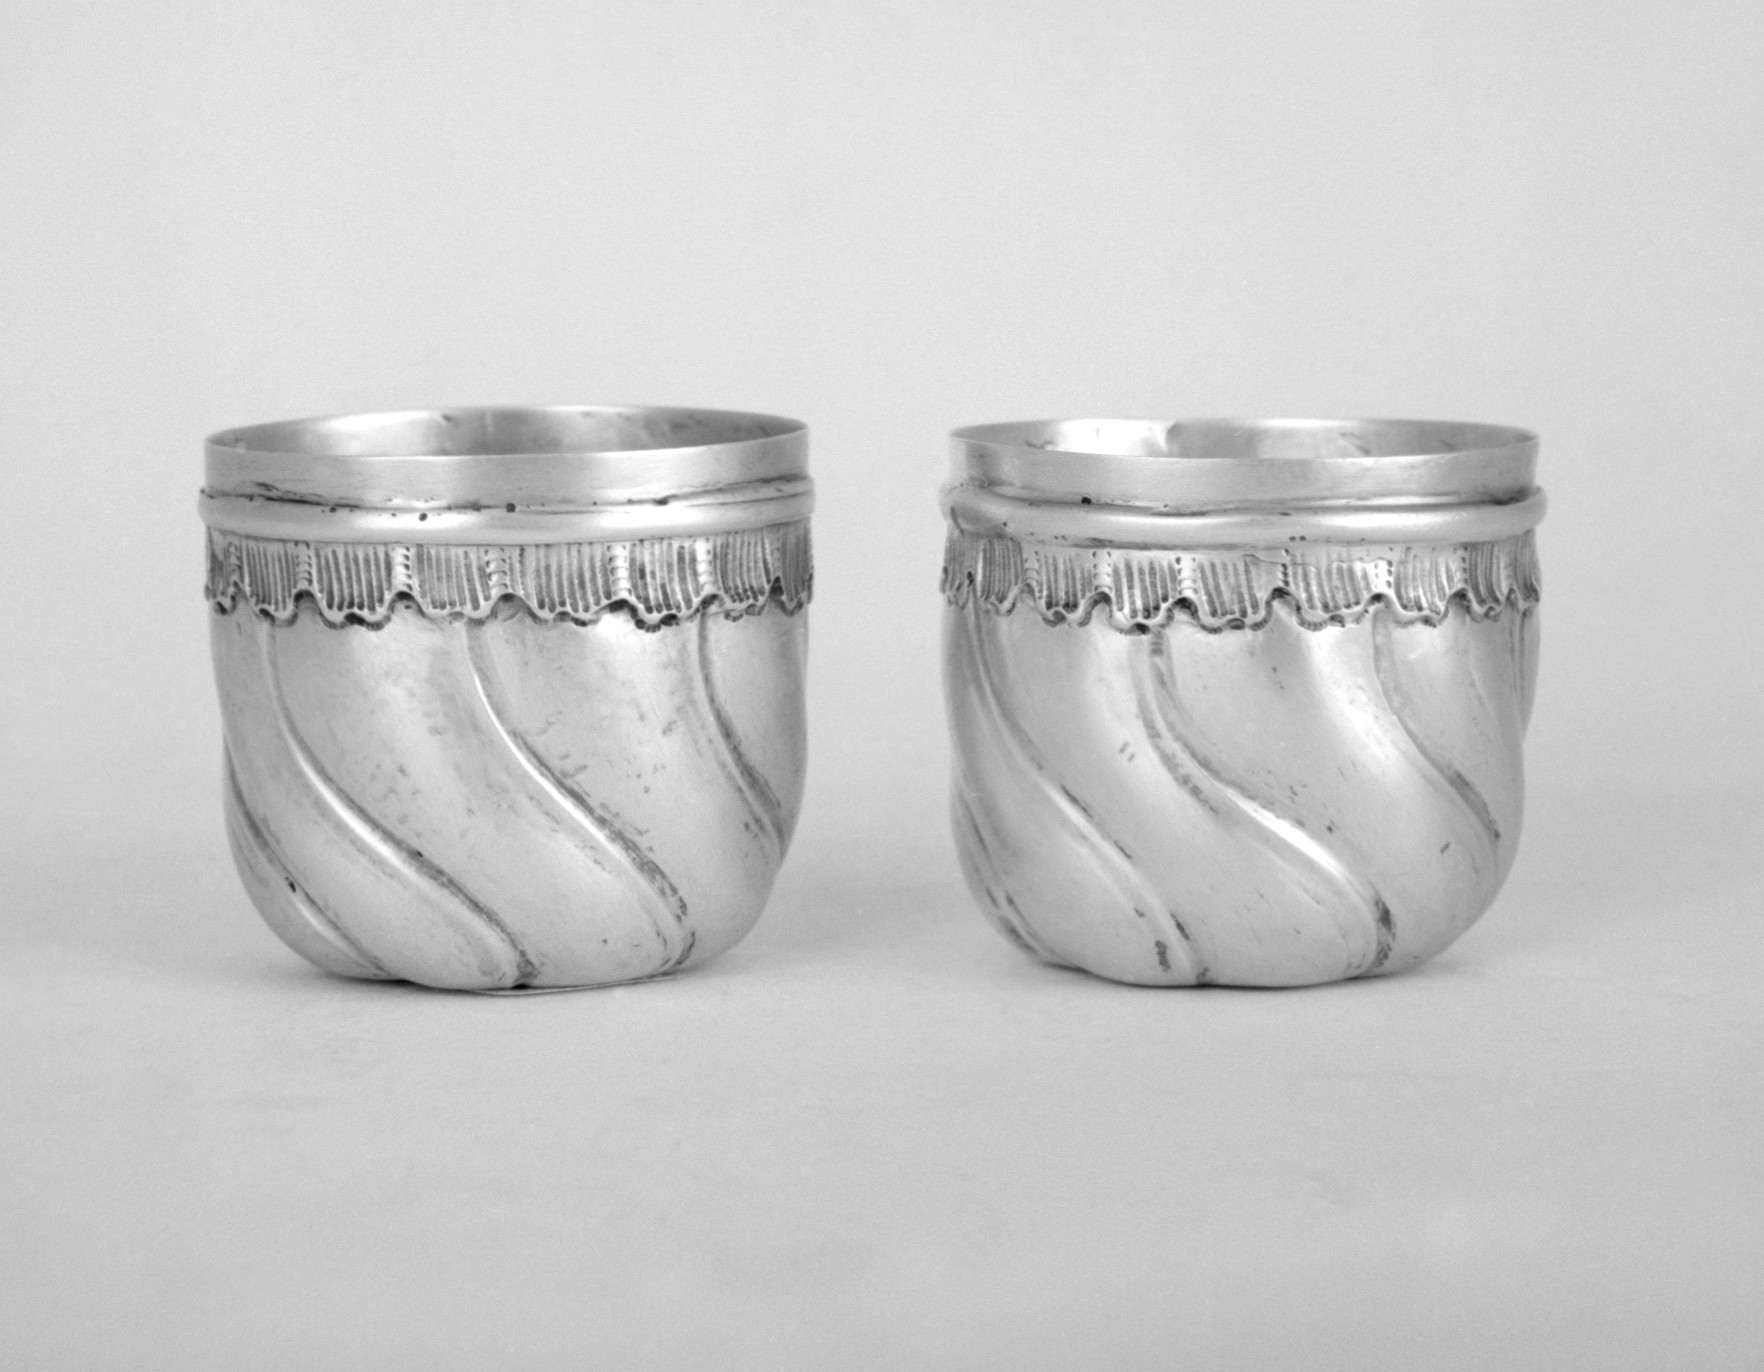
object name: double cup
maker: johann friedericus schloeff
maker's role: maker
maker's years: 1675-1775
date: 1701-1733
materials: gilt, silver